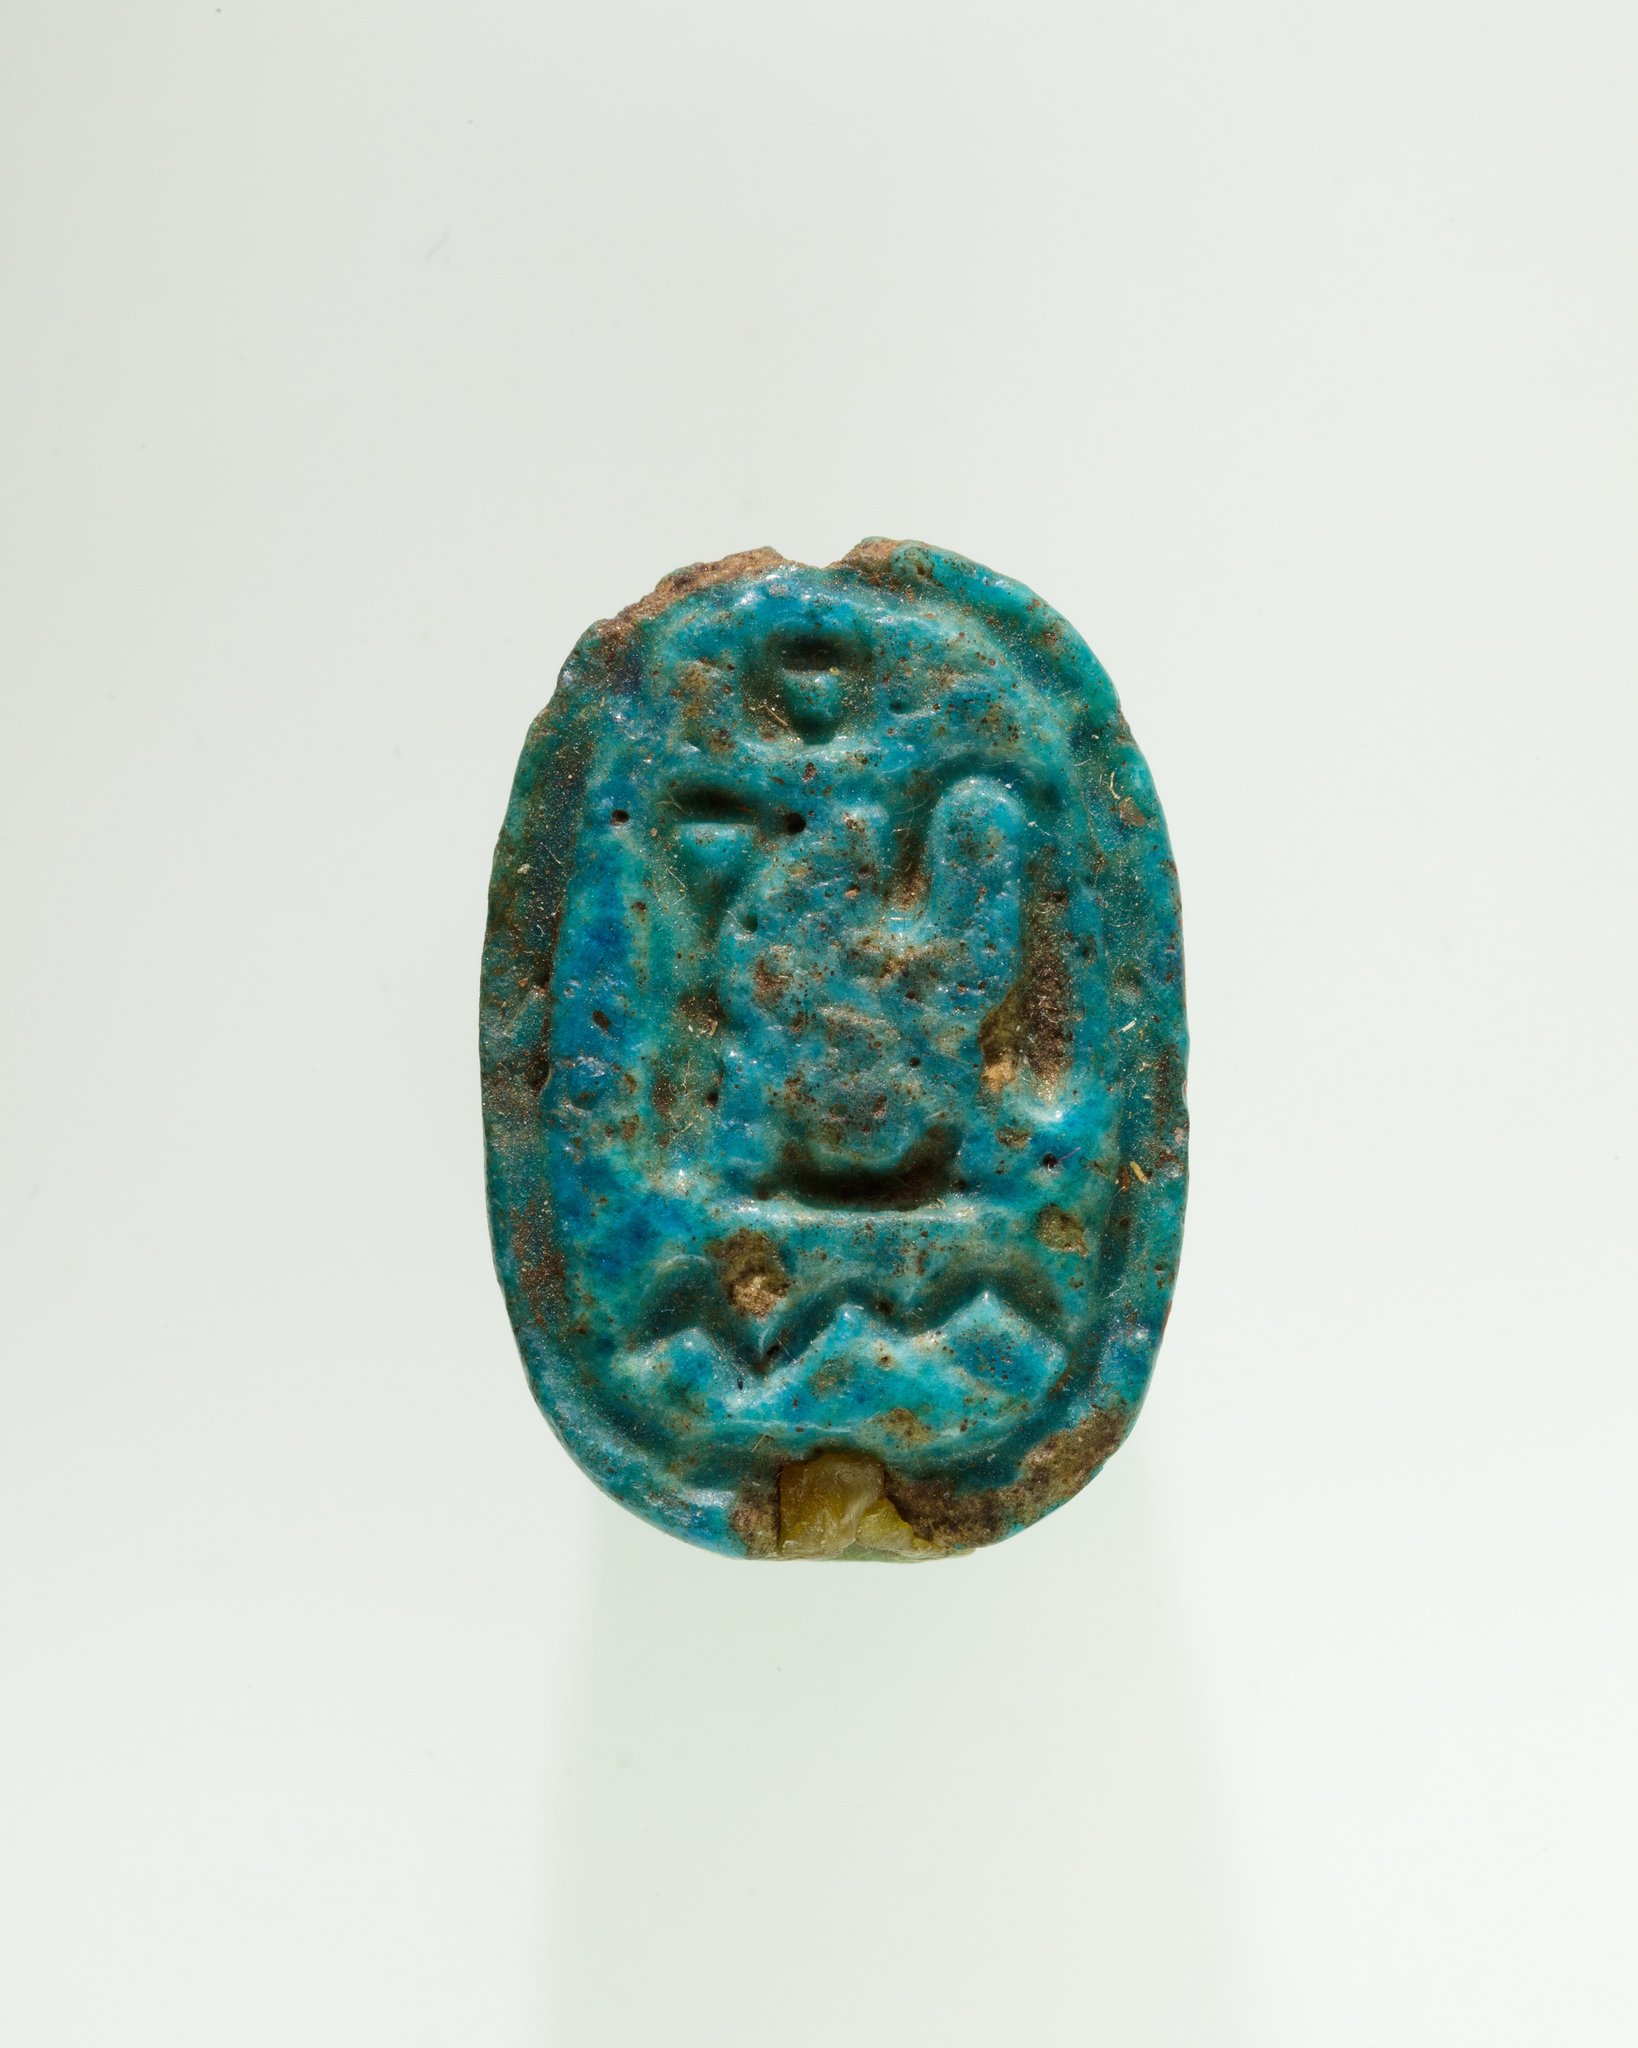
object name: scarab, sewadjenre, nebirierau i, royal, hieroglyph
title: Scarab of Nebirierau I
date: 1627-1601 BCE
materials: faience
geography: egypt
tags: scarabs